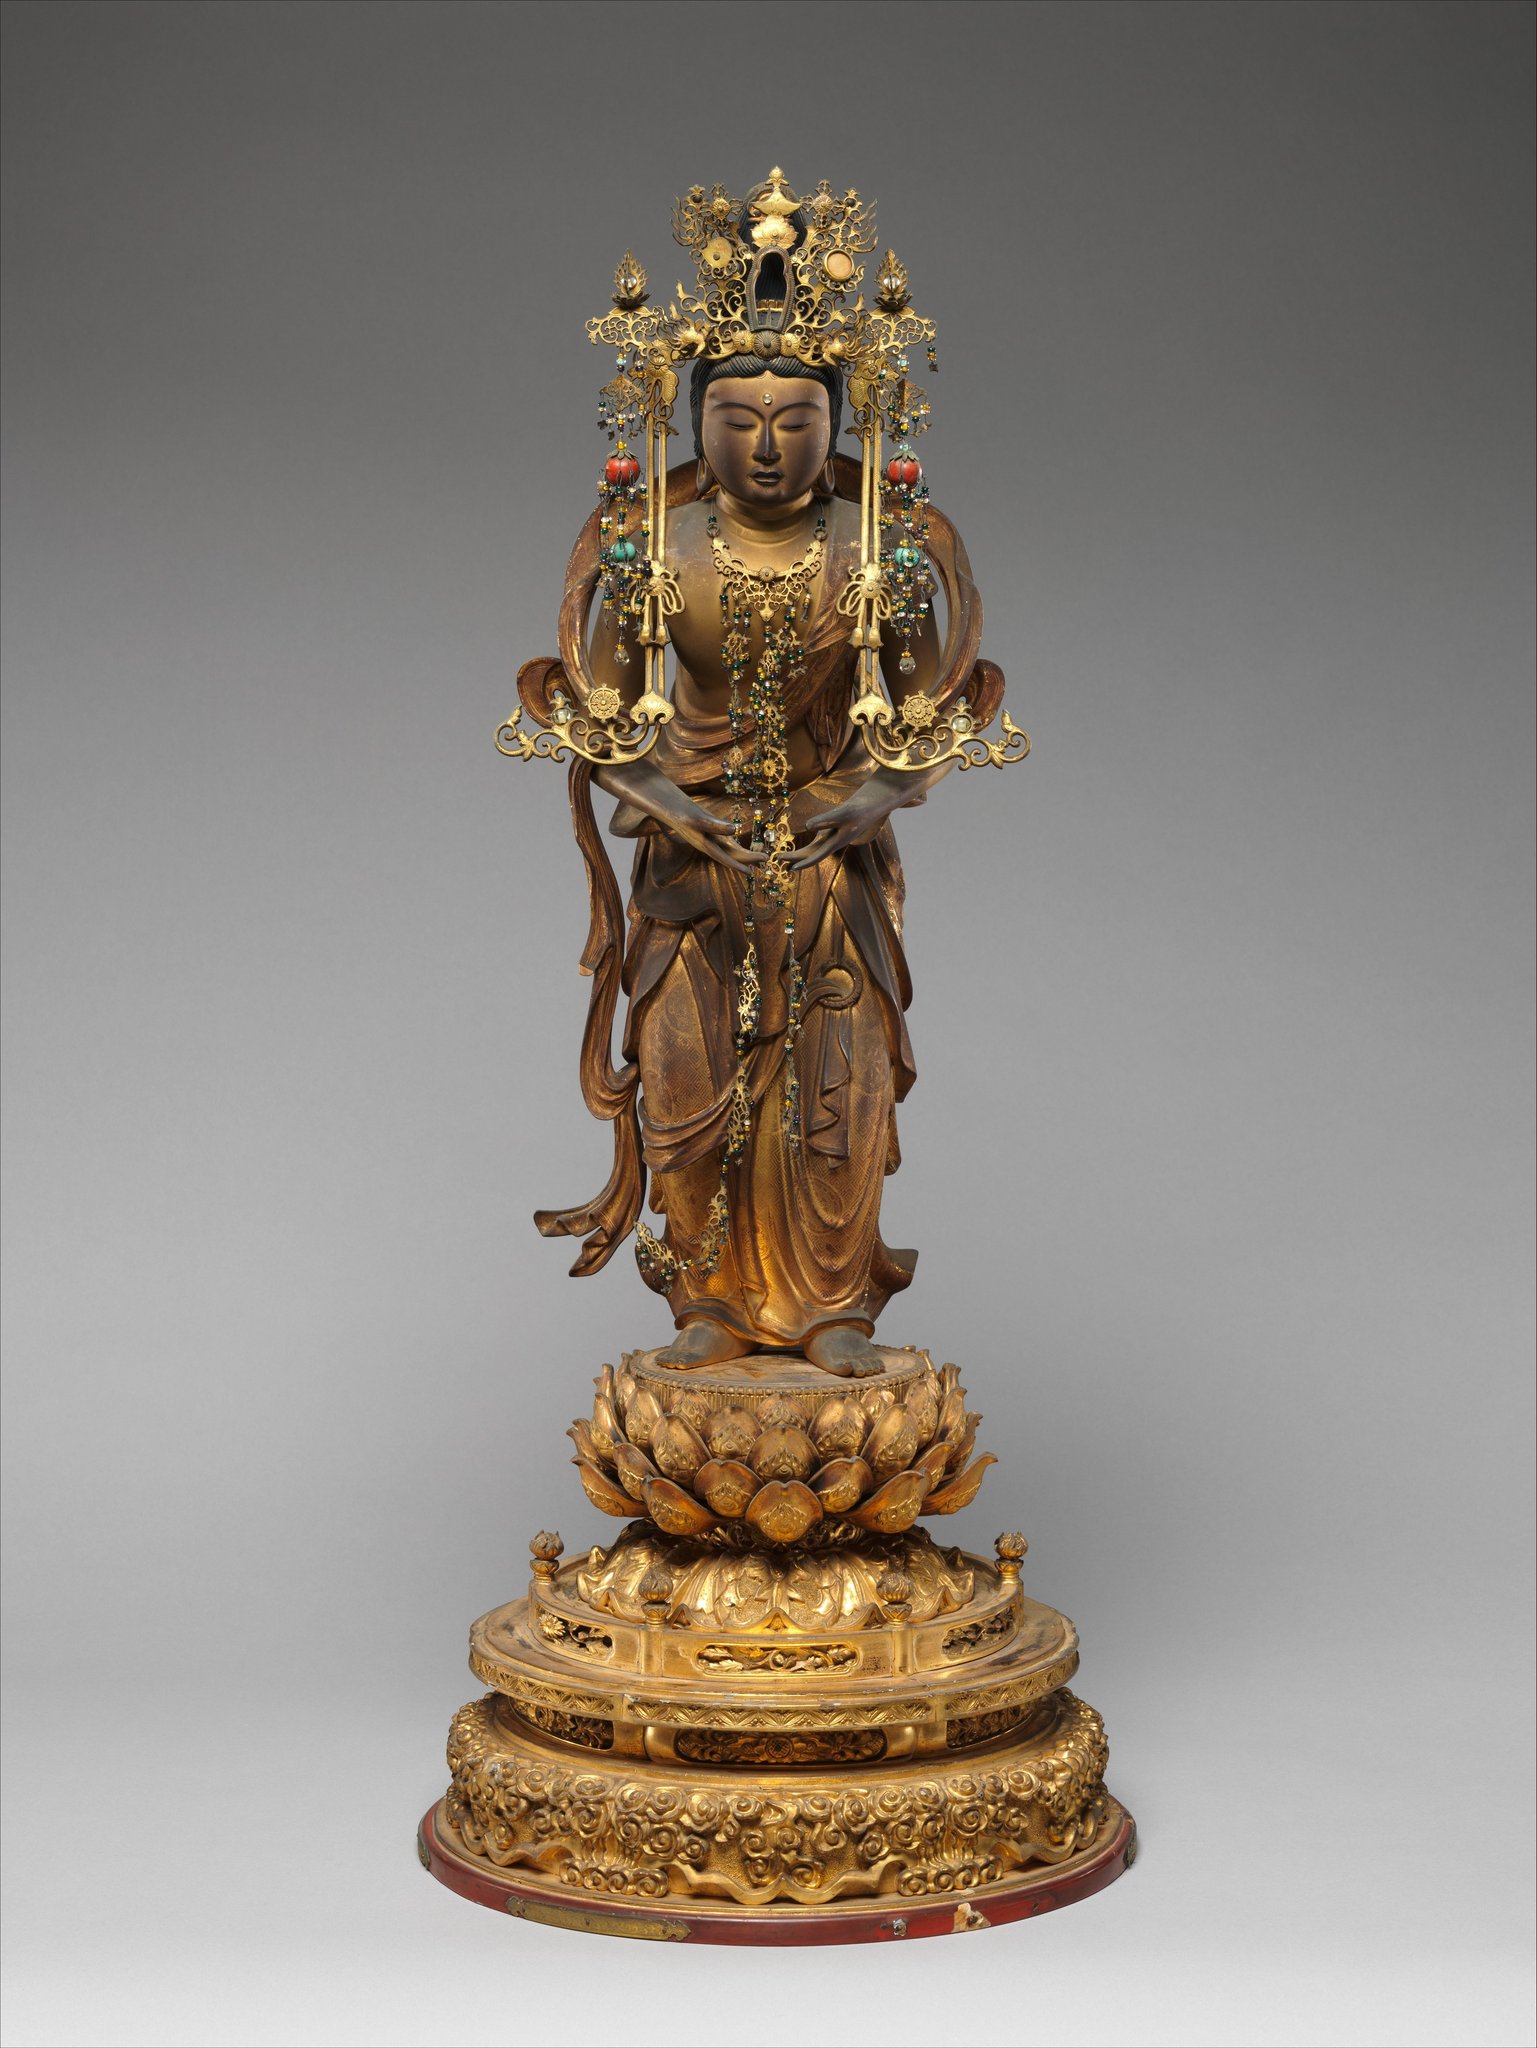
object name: figure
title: Bodhisattva Kannon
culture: japanese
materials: gold leaf, lacquer, metal, wood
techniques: cutting, kirikane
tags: buddhism,bodhisattvas